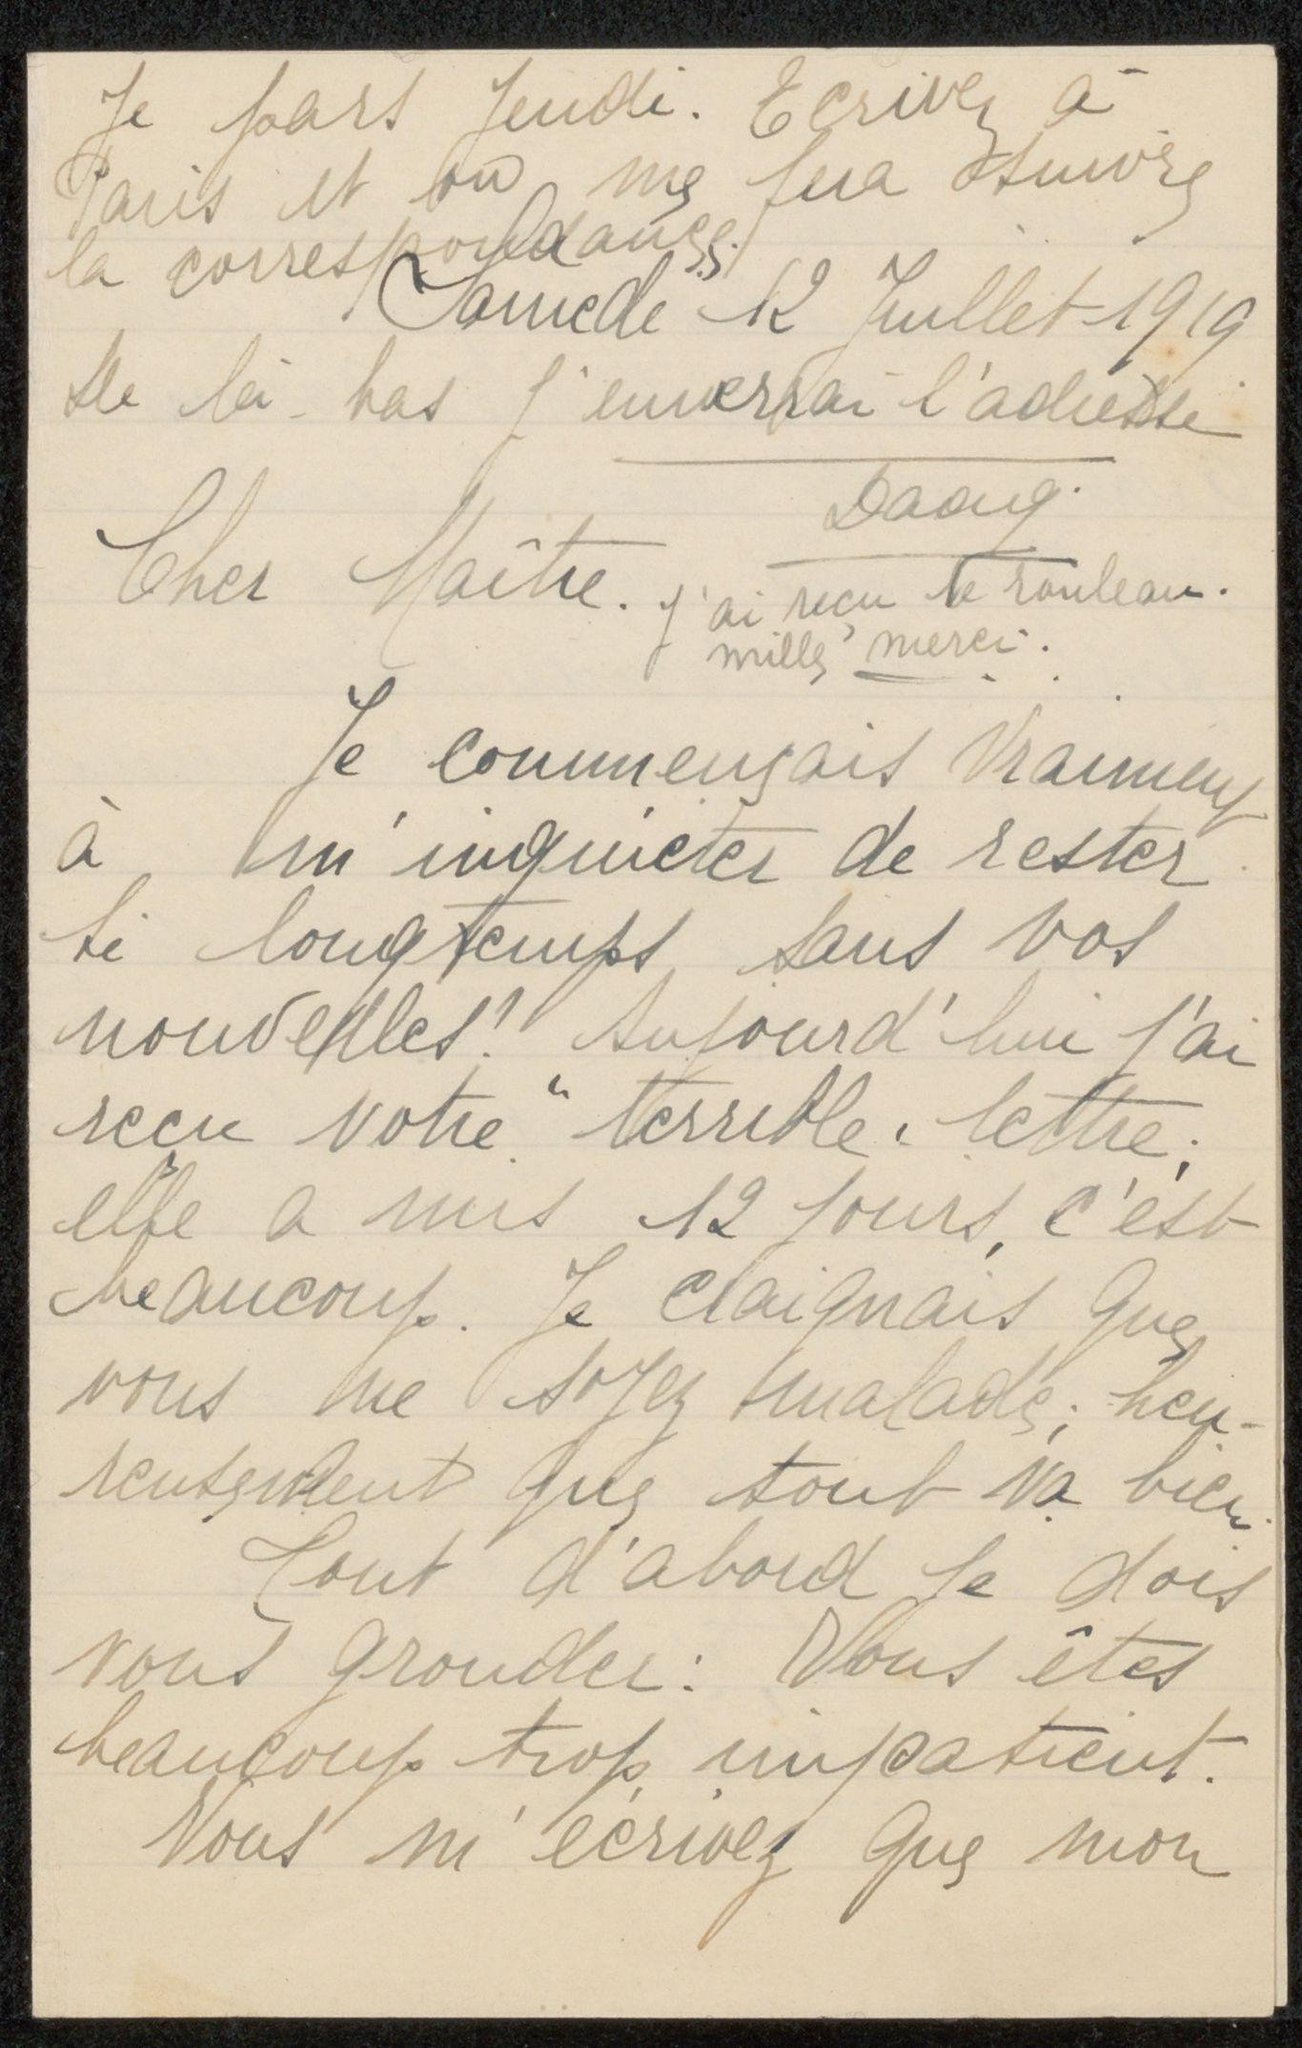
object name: letter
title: Brief aan Philip Zilcken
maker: rose imel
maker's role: draughtsman, painter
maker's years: 1901-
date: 1919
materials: ink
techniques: pen, writing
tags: the hague, painter, draughtsman, philip zilcken, workshop, studio of the artist (in general), artist at work, in his workshop - bb - out of doors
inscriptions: collector's mark: ‘RPK’